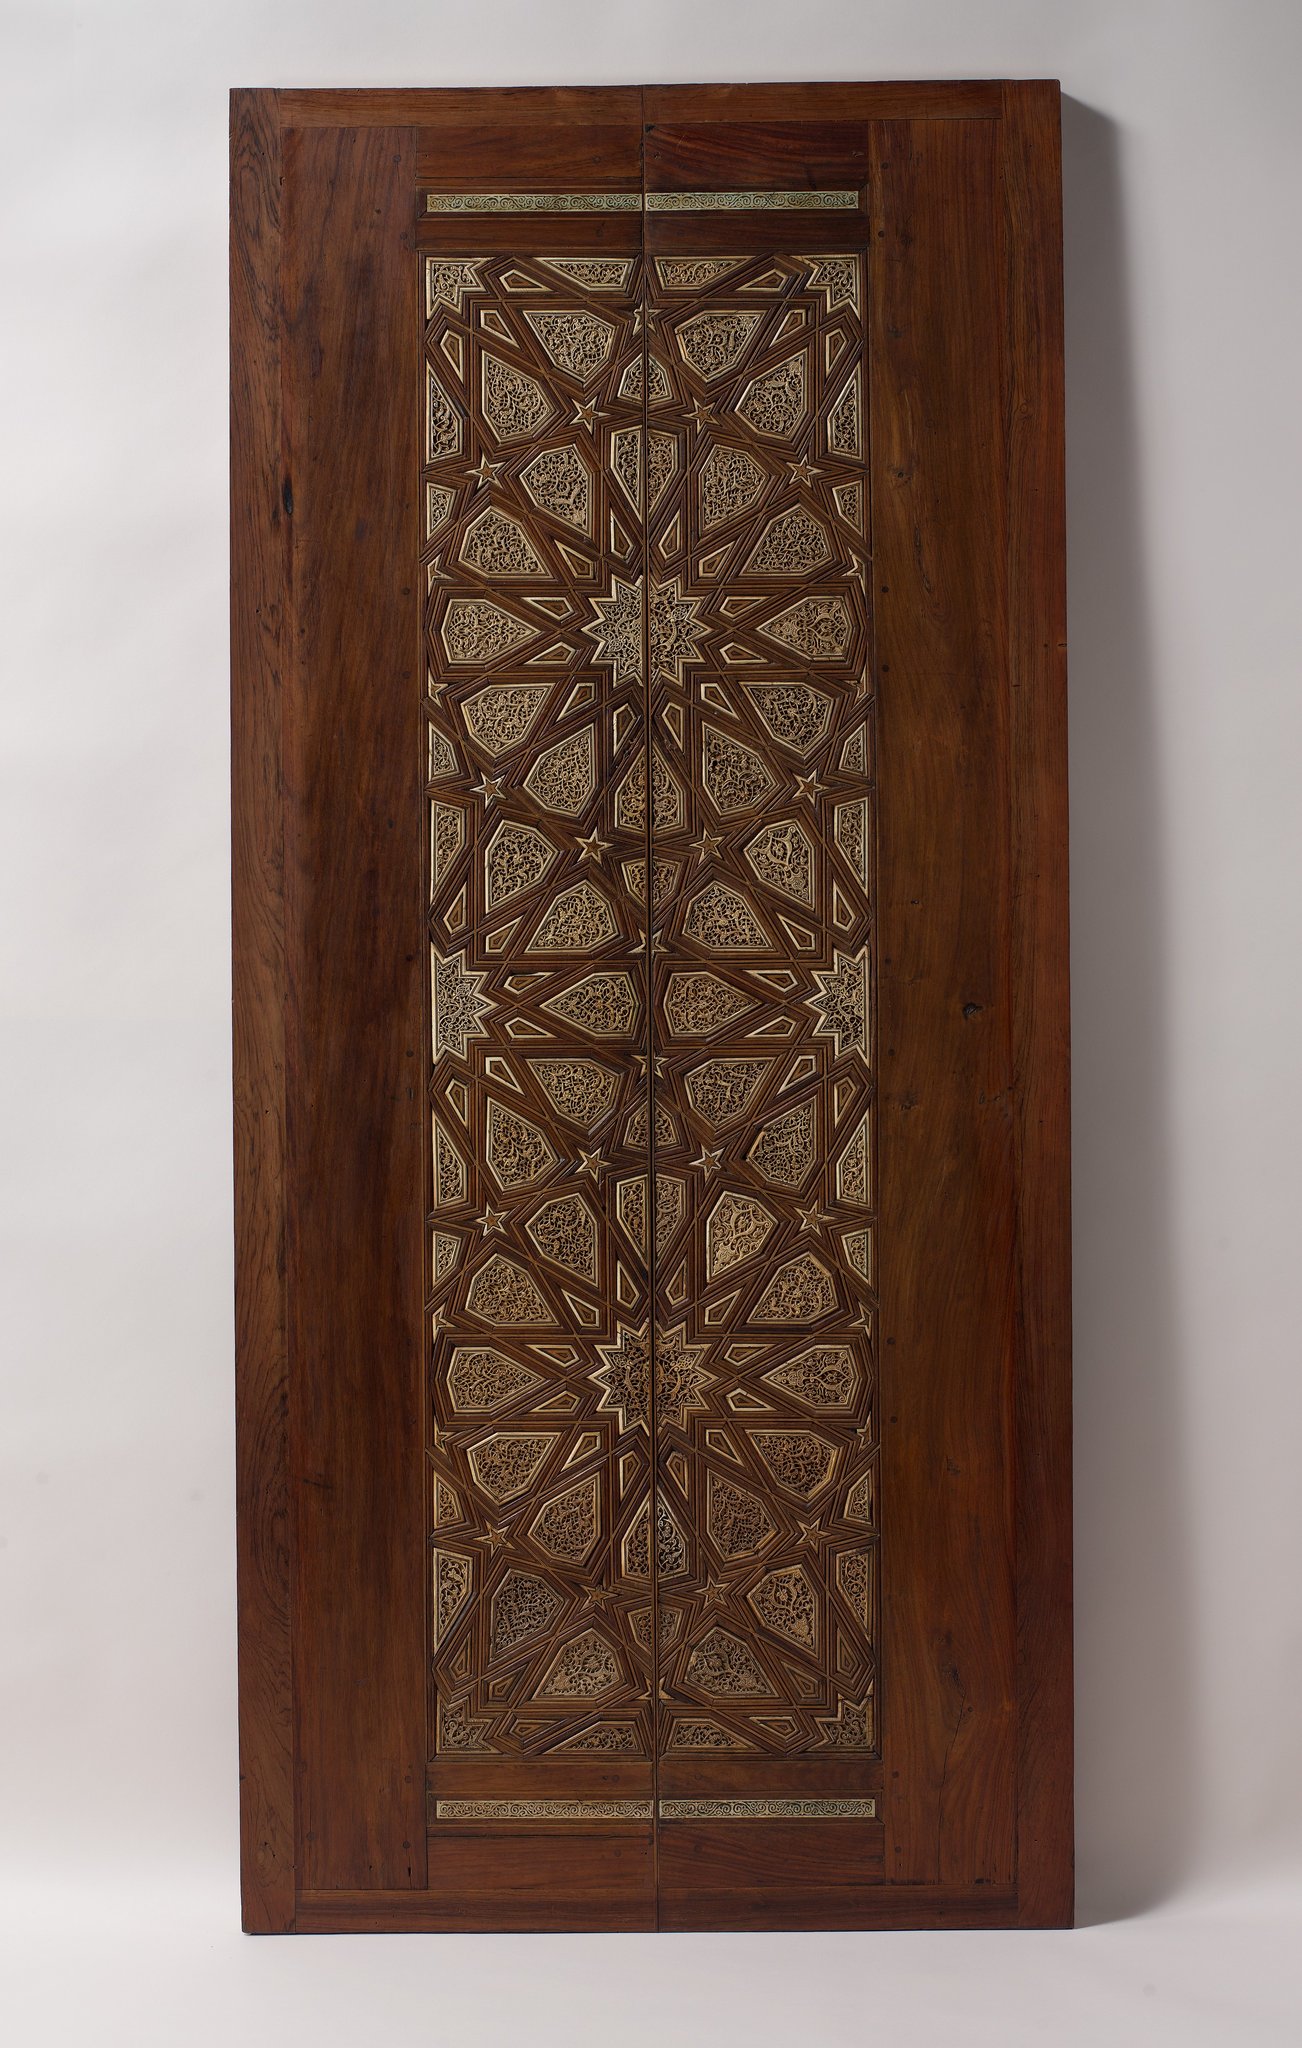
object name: door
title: Pair of Minbar Doors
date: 1325-1330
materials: wood, ivory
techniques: carving, inlay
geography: egypt